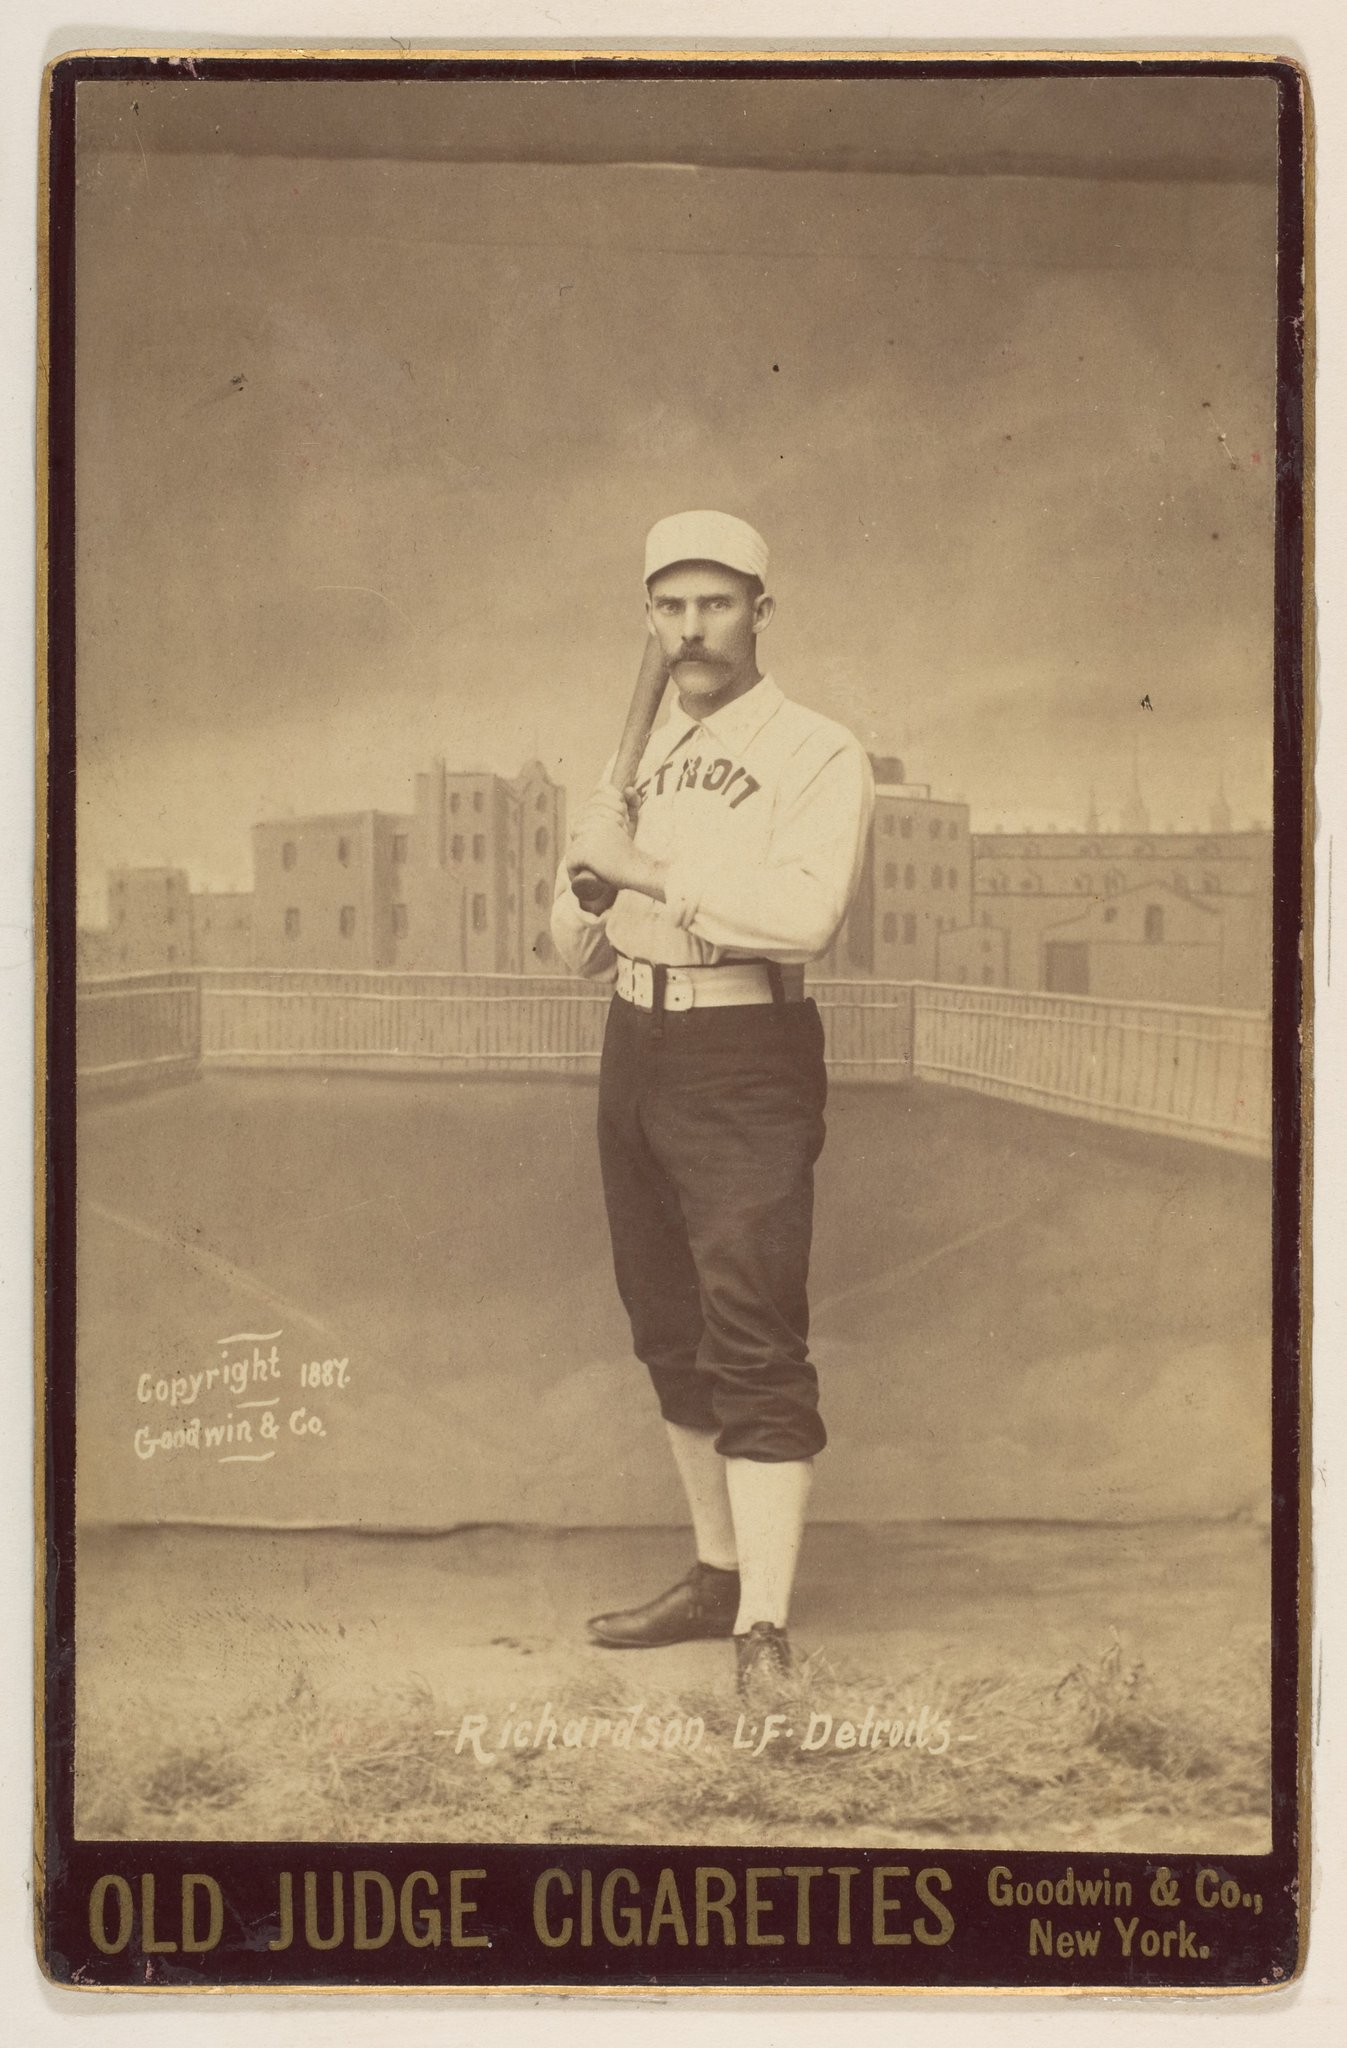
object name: baseball card, photograph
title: Hardy Richardson, Left Field, Detroit, from the series Old Judge Cigarettes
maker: goodwin & company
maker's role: publisher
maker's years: 1850-1950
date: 1887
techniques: albumen print, photography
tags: men,portraits,baseball,athletes